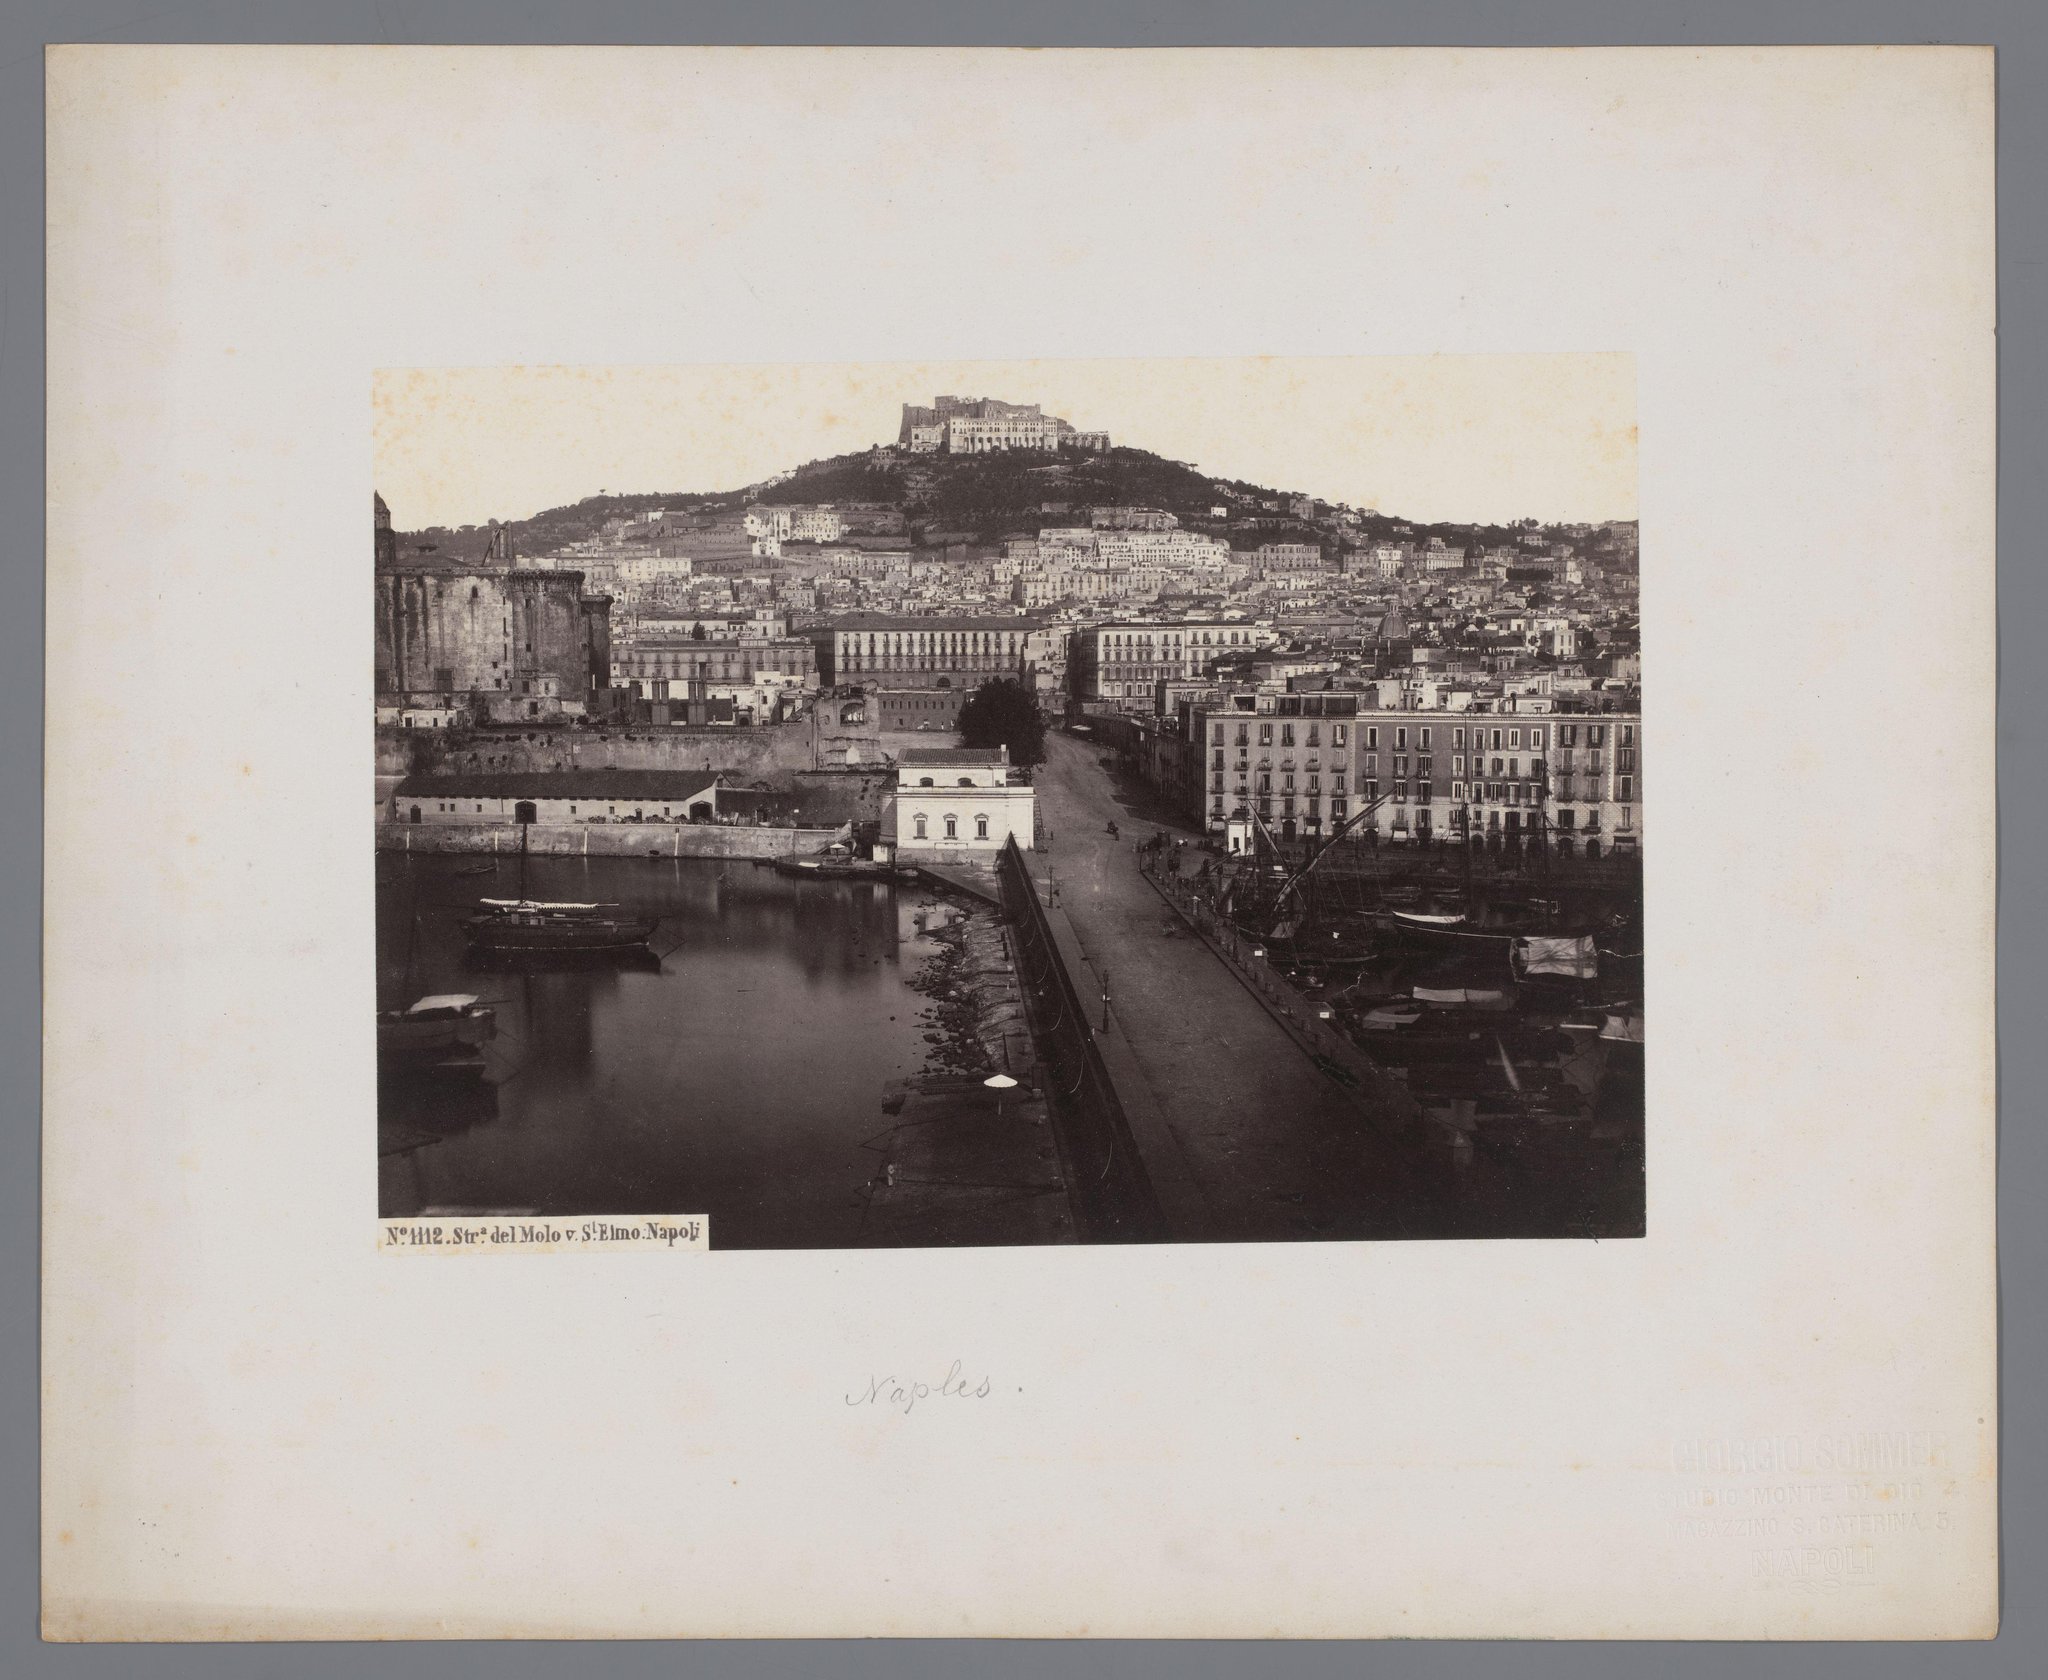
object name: photograph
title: Gezicht op het kasteel Sant'Elmo op de berg Vomero te Napels, Italië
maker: giorgio sommer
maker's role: fotograaf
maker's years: 1834-1914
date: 1890-1910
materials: cardboard, paper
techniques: albumen print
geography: naples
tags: city-view in general; 'veduta', castle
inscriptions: inscription: ‘Napels.’, address: ‘GIORGIO SOMMER/ STUDIO MONTE DI DIO 4./ MAGAZZINO S. CATERINA 5./ NAPOLI’, number: ‘No. 1112.’, number: ‘22’